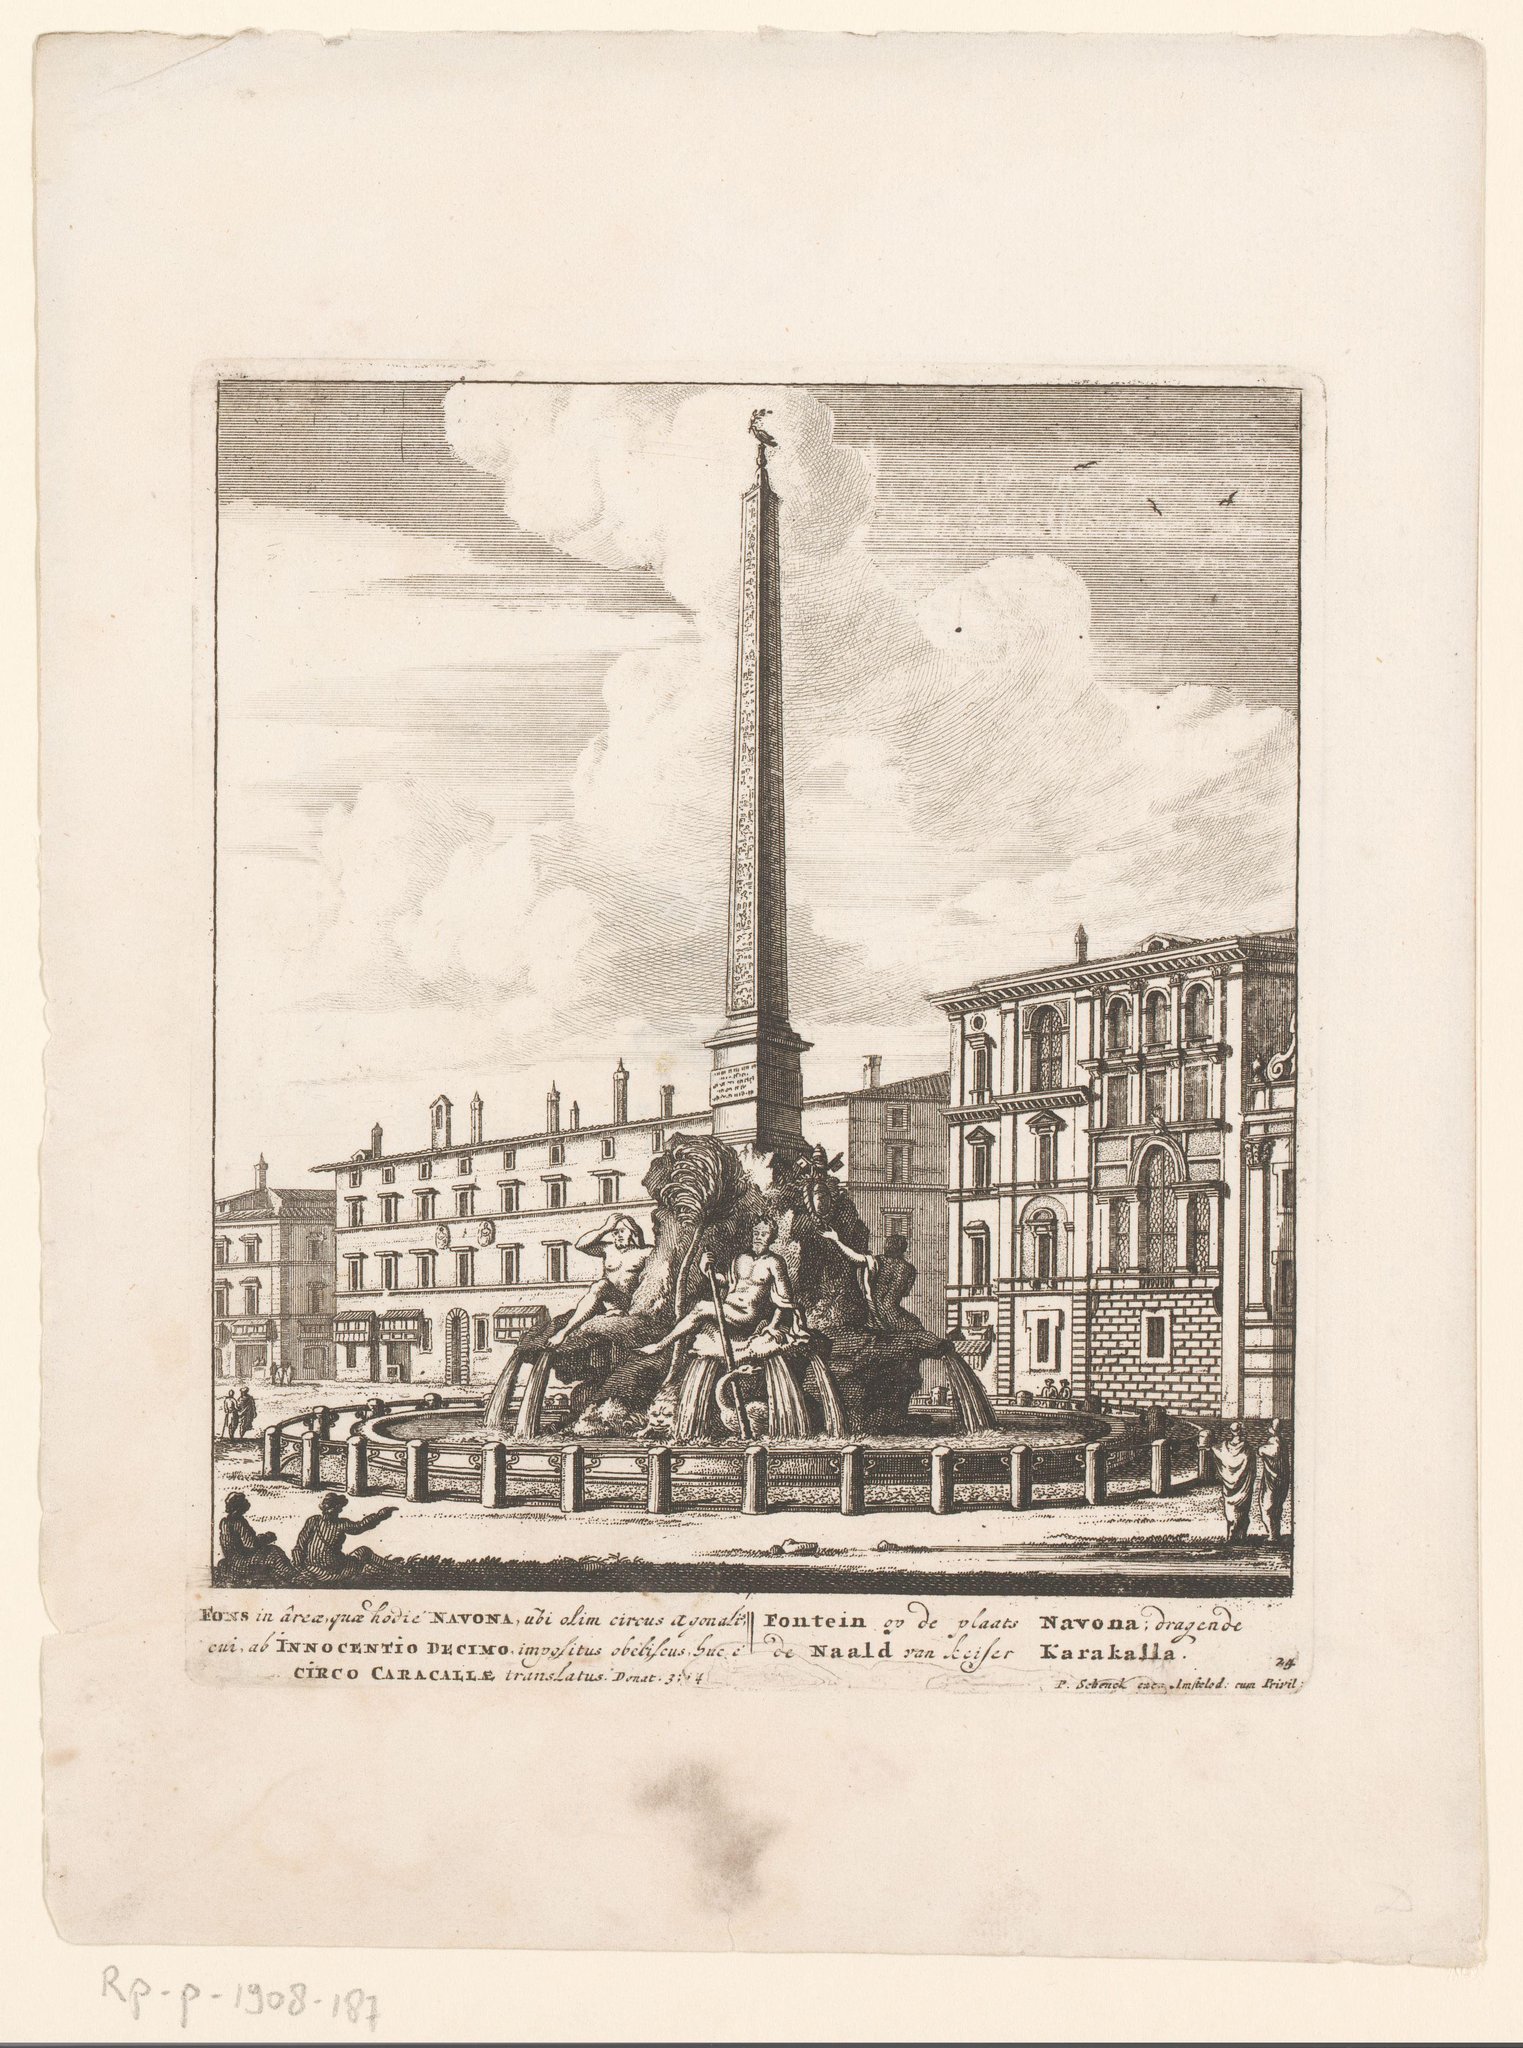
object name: print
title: Gezicht op de Vierstromenfontein op het Piazza Navona, te Rome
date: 1705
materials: paper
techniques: engraving, etching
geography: amsterdam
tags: obelisk, needle, ornamental fountain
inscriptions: collector's mark: Lugt 2228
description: Prent ook gebruikt in: Schenck, Pieter. Roma aeterna Petri Schenkii, sive, ipsius Aedificiorum romanorum, integrorum collapsorumque (...). Amsterdam: Pieter Schenck (I), 1705.